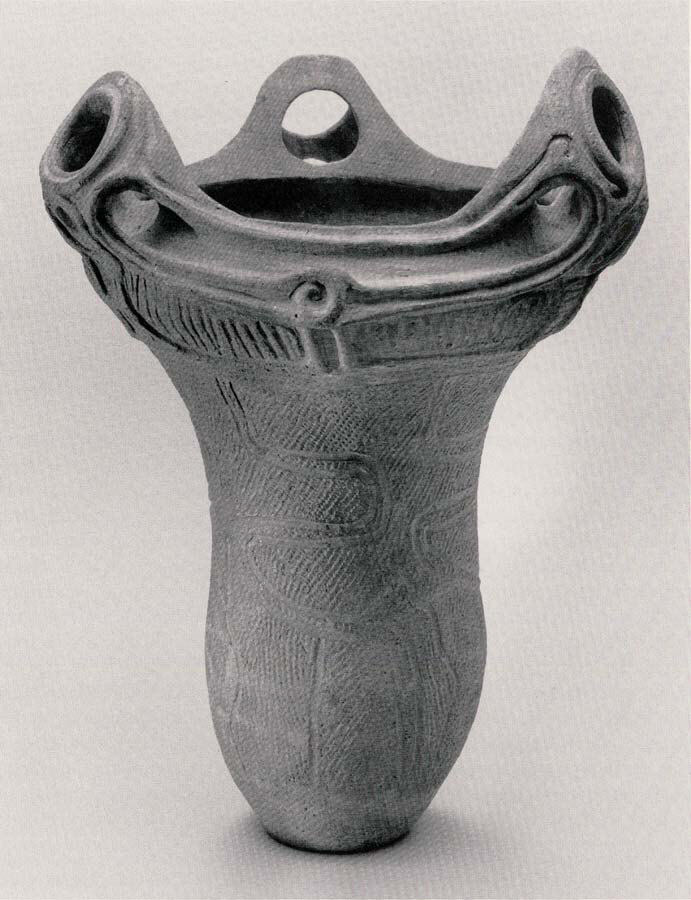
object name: vessel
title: Deep Vessel with Handles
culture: japanese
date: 3500-2500 BCE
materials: cord, earthenware